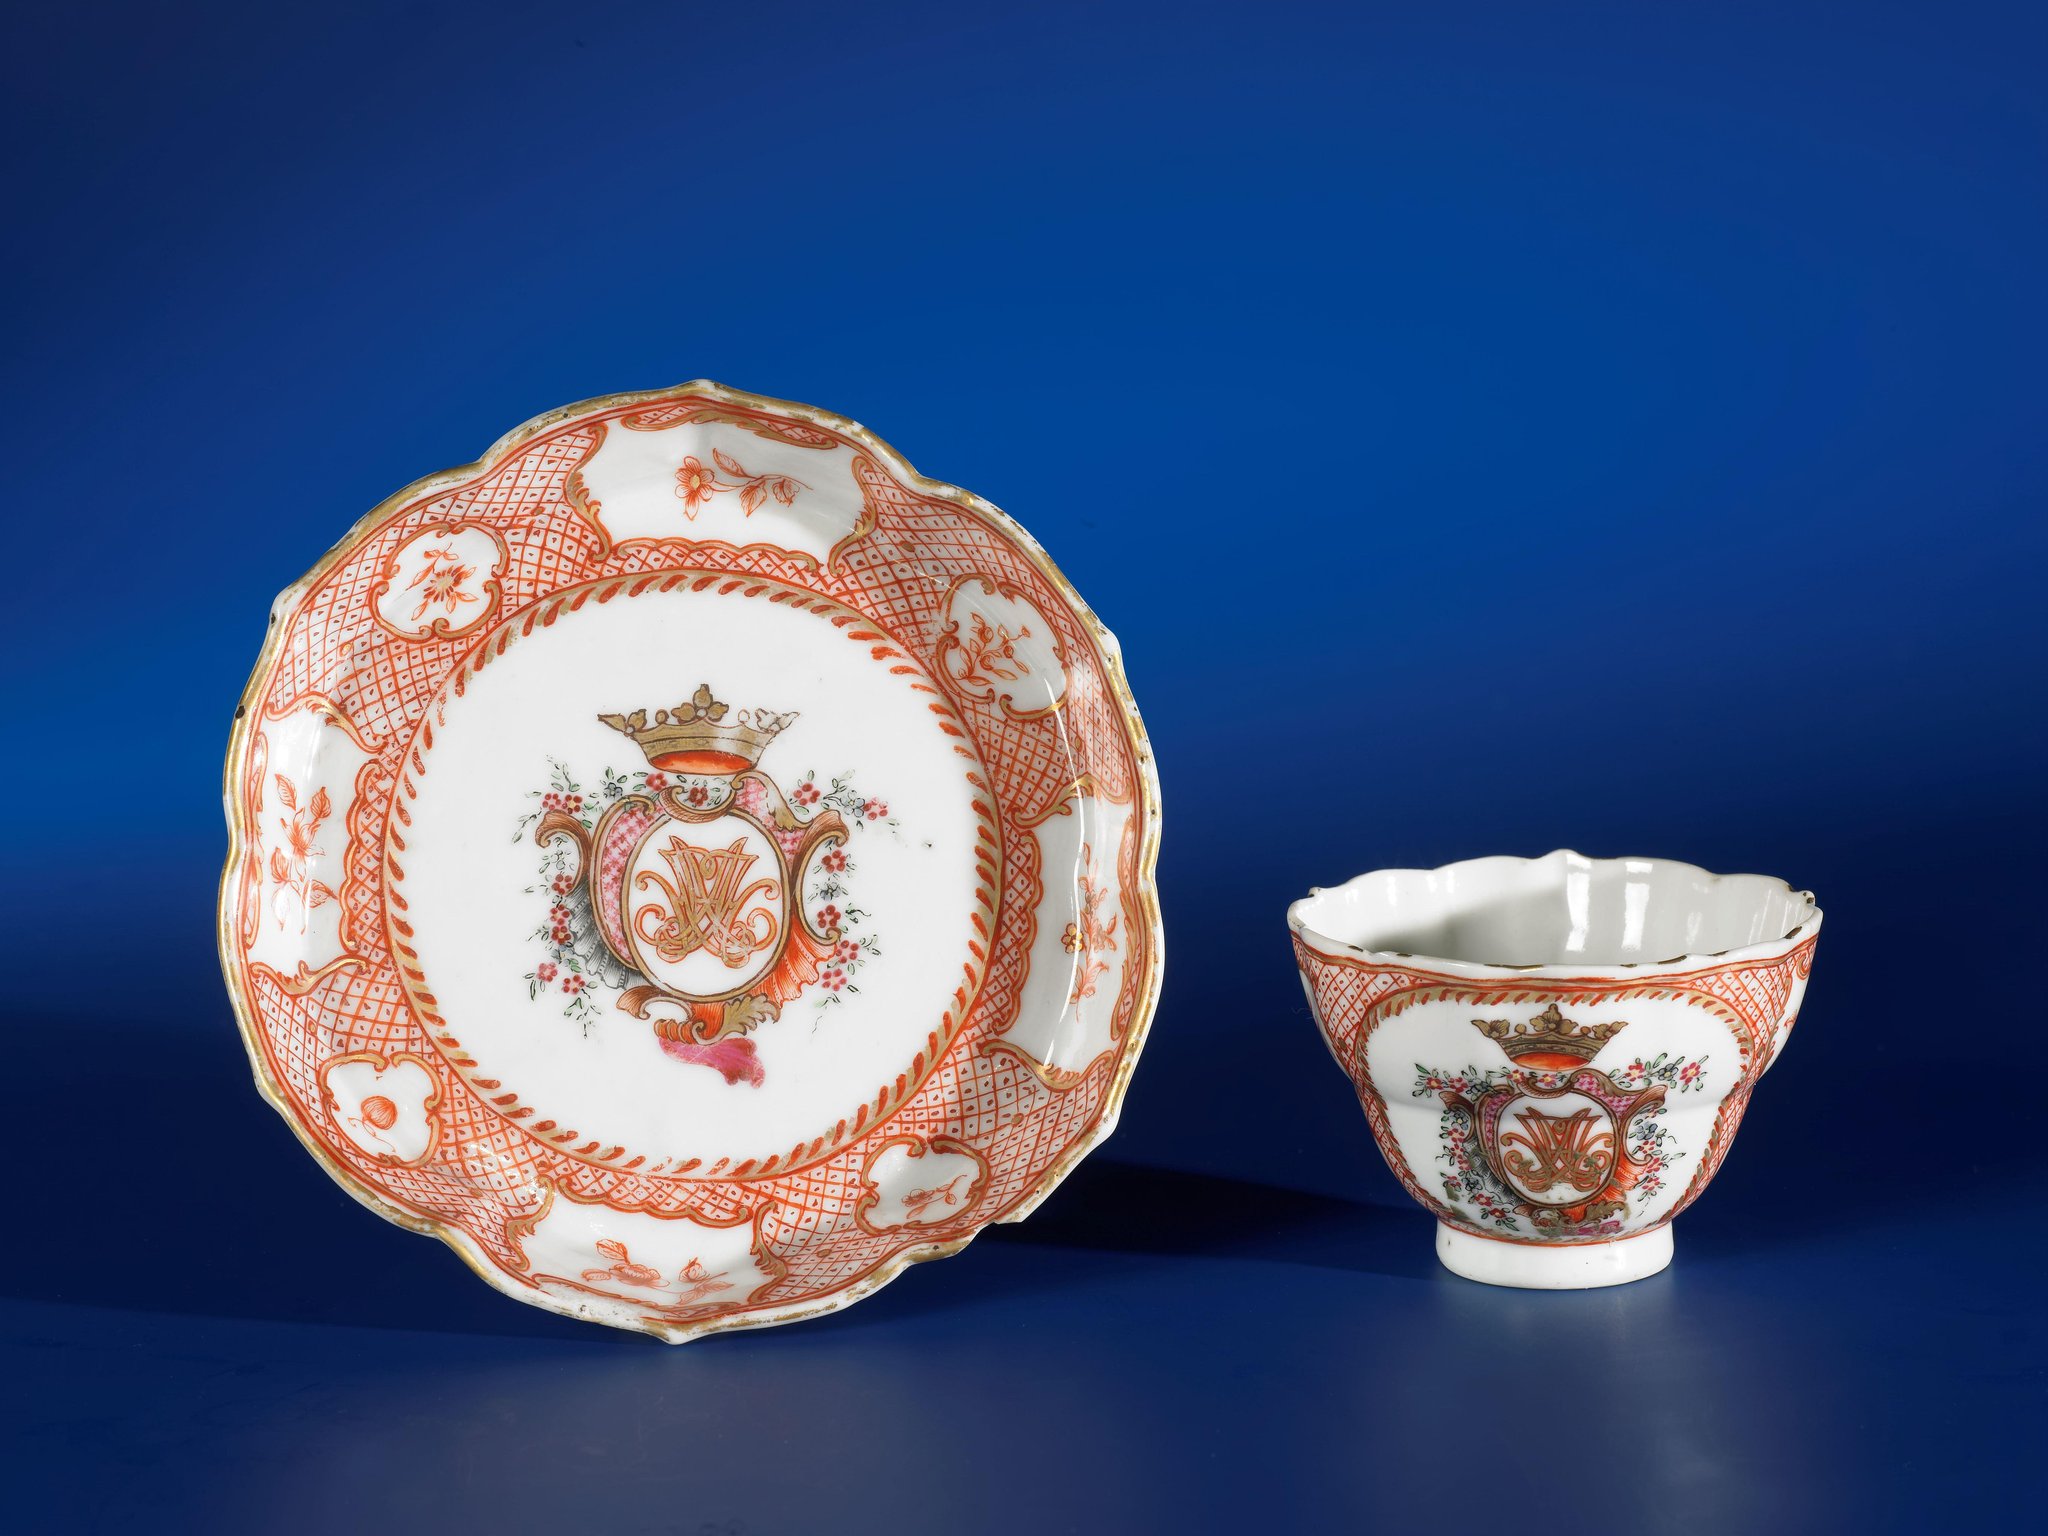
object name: cup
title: Cup with a monogram in a crest in a medallion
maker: Anonymous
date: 1725-1749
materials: glaze, gold, paint, porcelain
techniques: firing, gilding, turning, vitrification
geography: china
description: Kop van porselein, beschilderd op het glazuur in blauw, rood, roze, groen, geel, zwart en goud. De wand van de kop verdeeld in twee secties, waarvan de bovenste met geribde wand, en met een accoladevormige rand. Op de wand het monogram 'JM' in een gekroond medaillon met schelpmotief, servetwerk en bloemtakken; om het medaillon en op de wand servetwerk met hierin uitgespaard vier kleine en vier grote cartouches met bloemtak. Twee barsten in de wand van de kop. Europese voorstelling in emailkleuren.